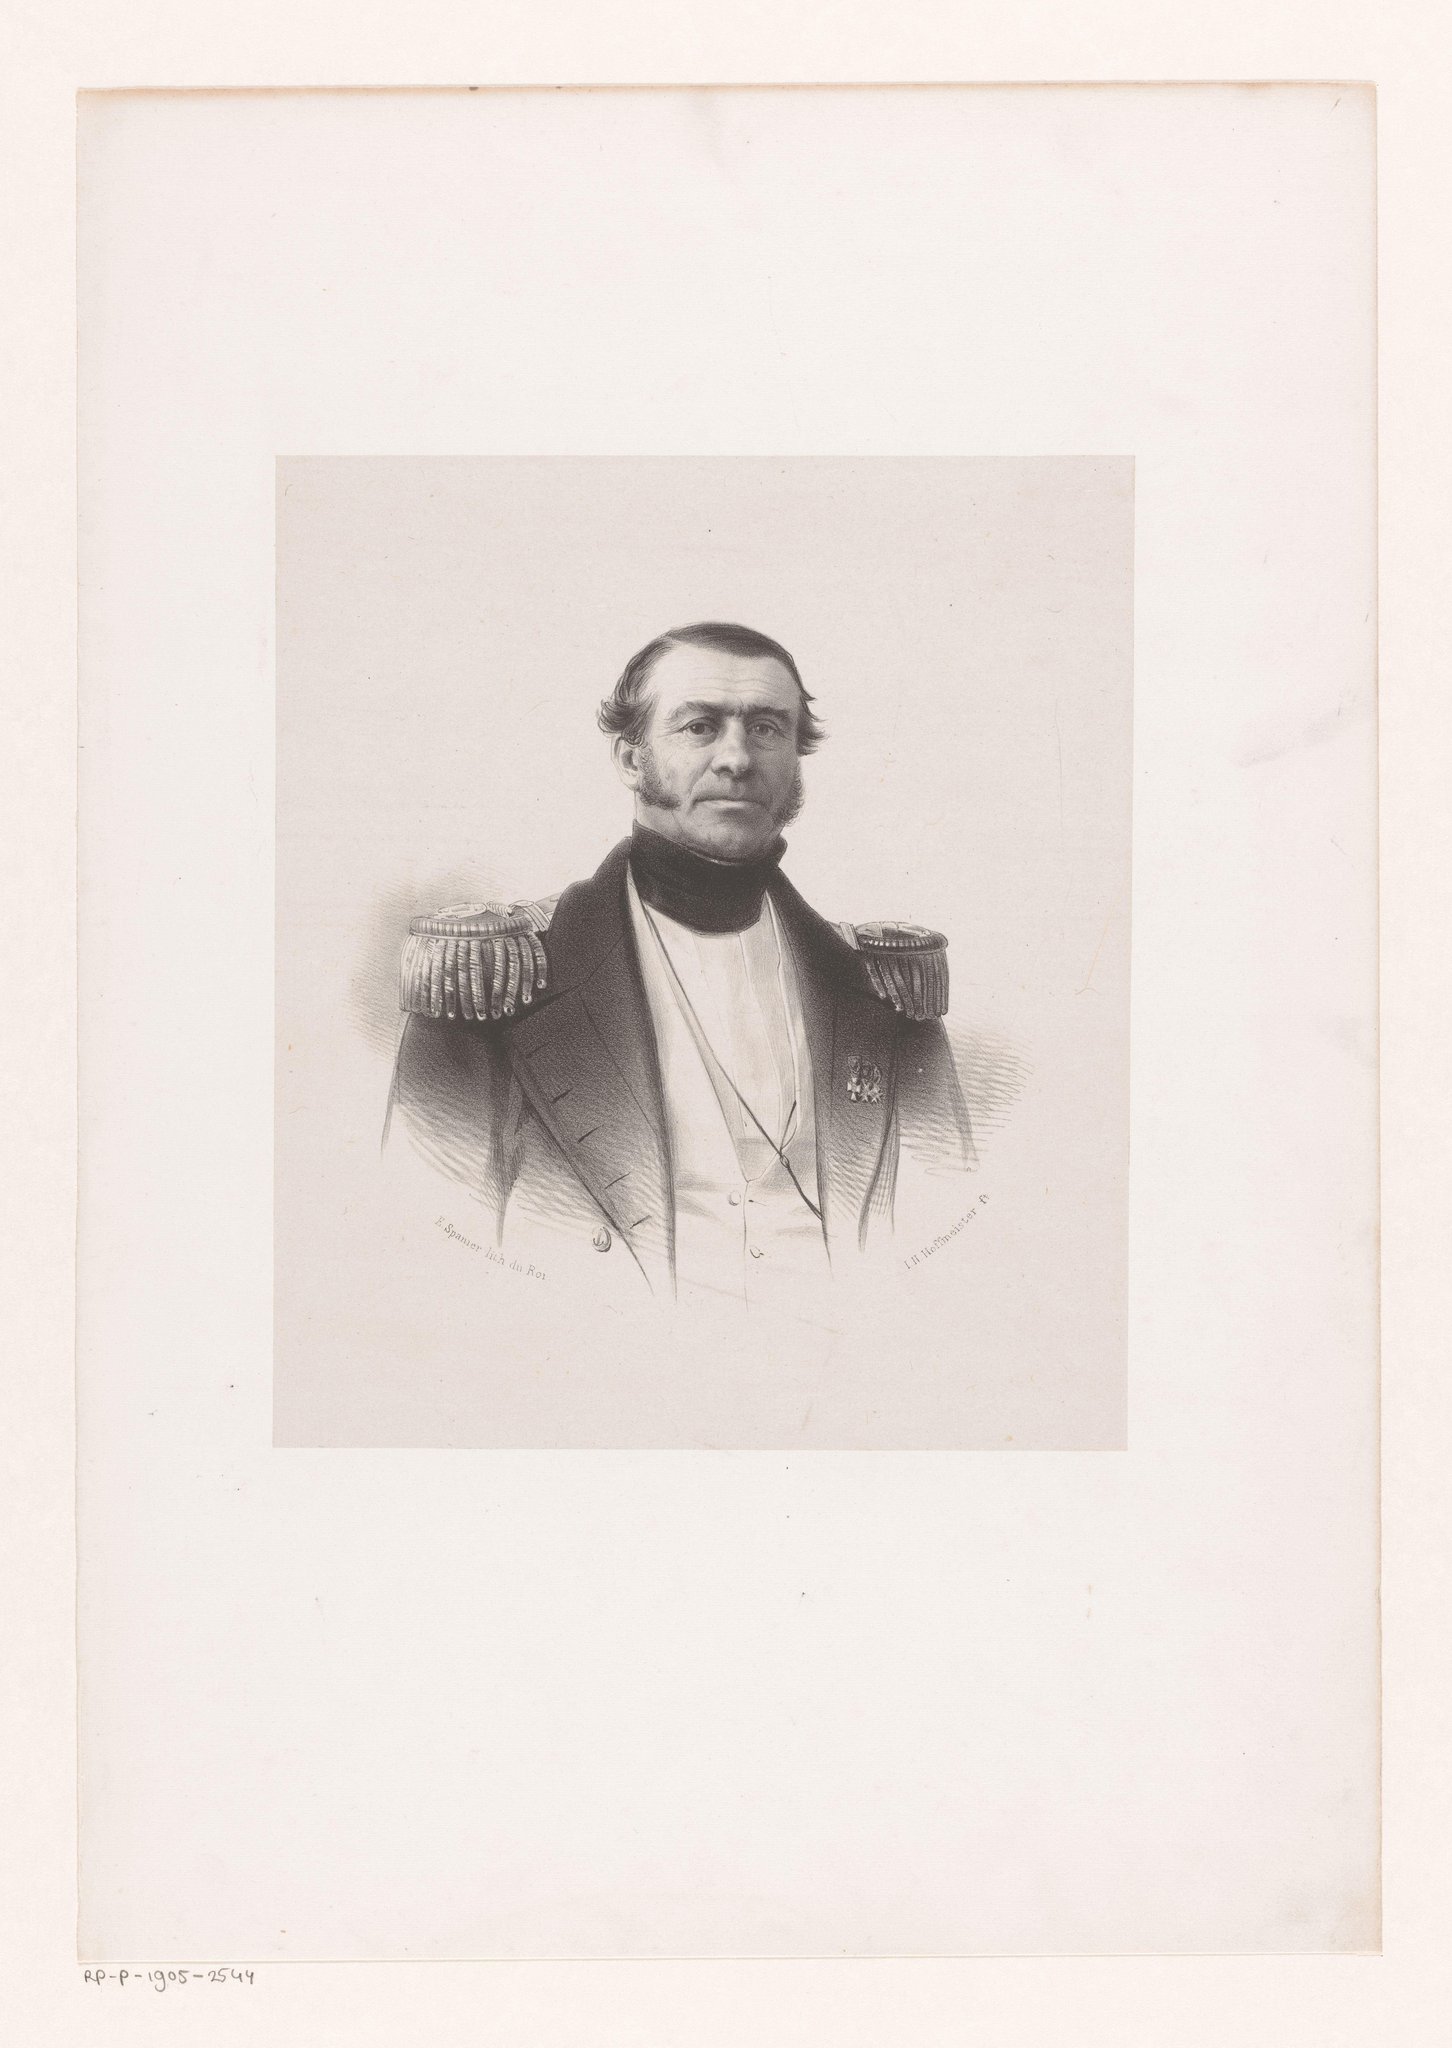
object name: print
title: Portret van een onbekende zeeofficier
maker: johan hendrik hoffmeister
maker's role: print maker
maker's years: 1823-1904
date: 1851-1883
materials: paper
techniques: lithograph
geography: netherlands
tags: historical persons (+ (full) bust portrait)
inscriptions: collector's mark: Lugt 2228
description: De geportretteerde draagt een jas met epauletten en drie ridderorden.